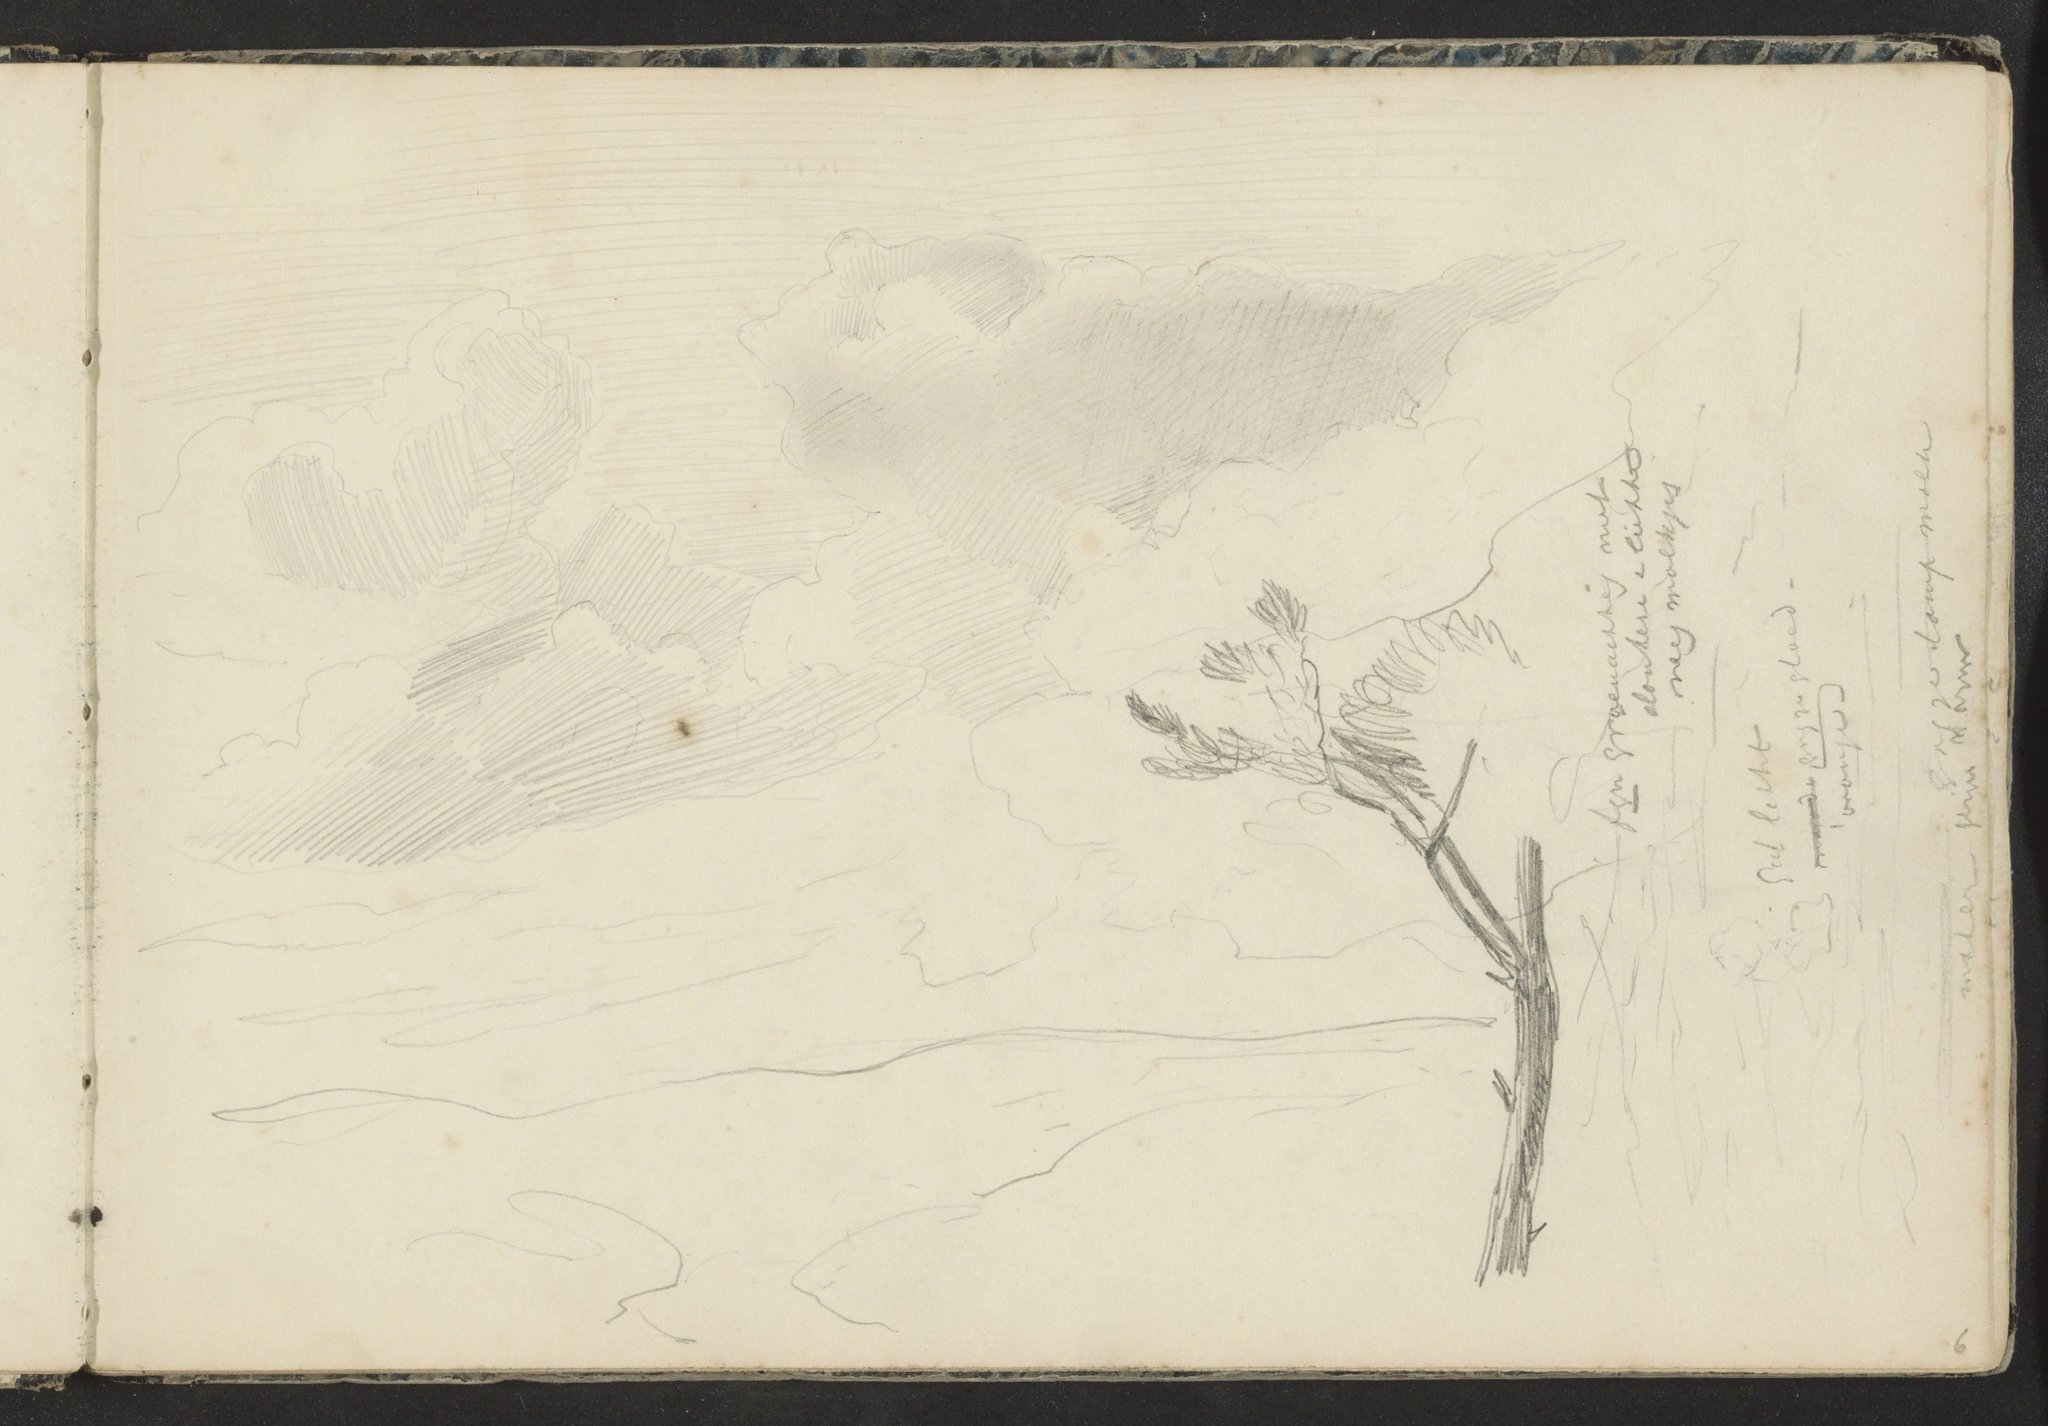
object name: sketchbook leaf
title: Landschap met een boom en een wolkenlucht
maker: johannes tavenraat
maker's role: draughtsman, painter, print maker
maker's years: 1809-1881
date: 1843-1857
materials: paper, pencil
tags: trees, landscapes, clouds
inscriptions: kleurnotitie, handgeschreven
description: Blad 6 recto uit een schetsboek met 44 bladen.